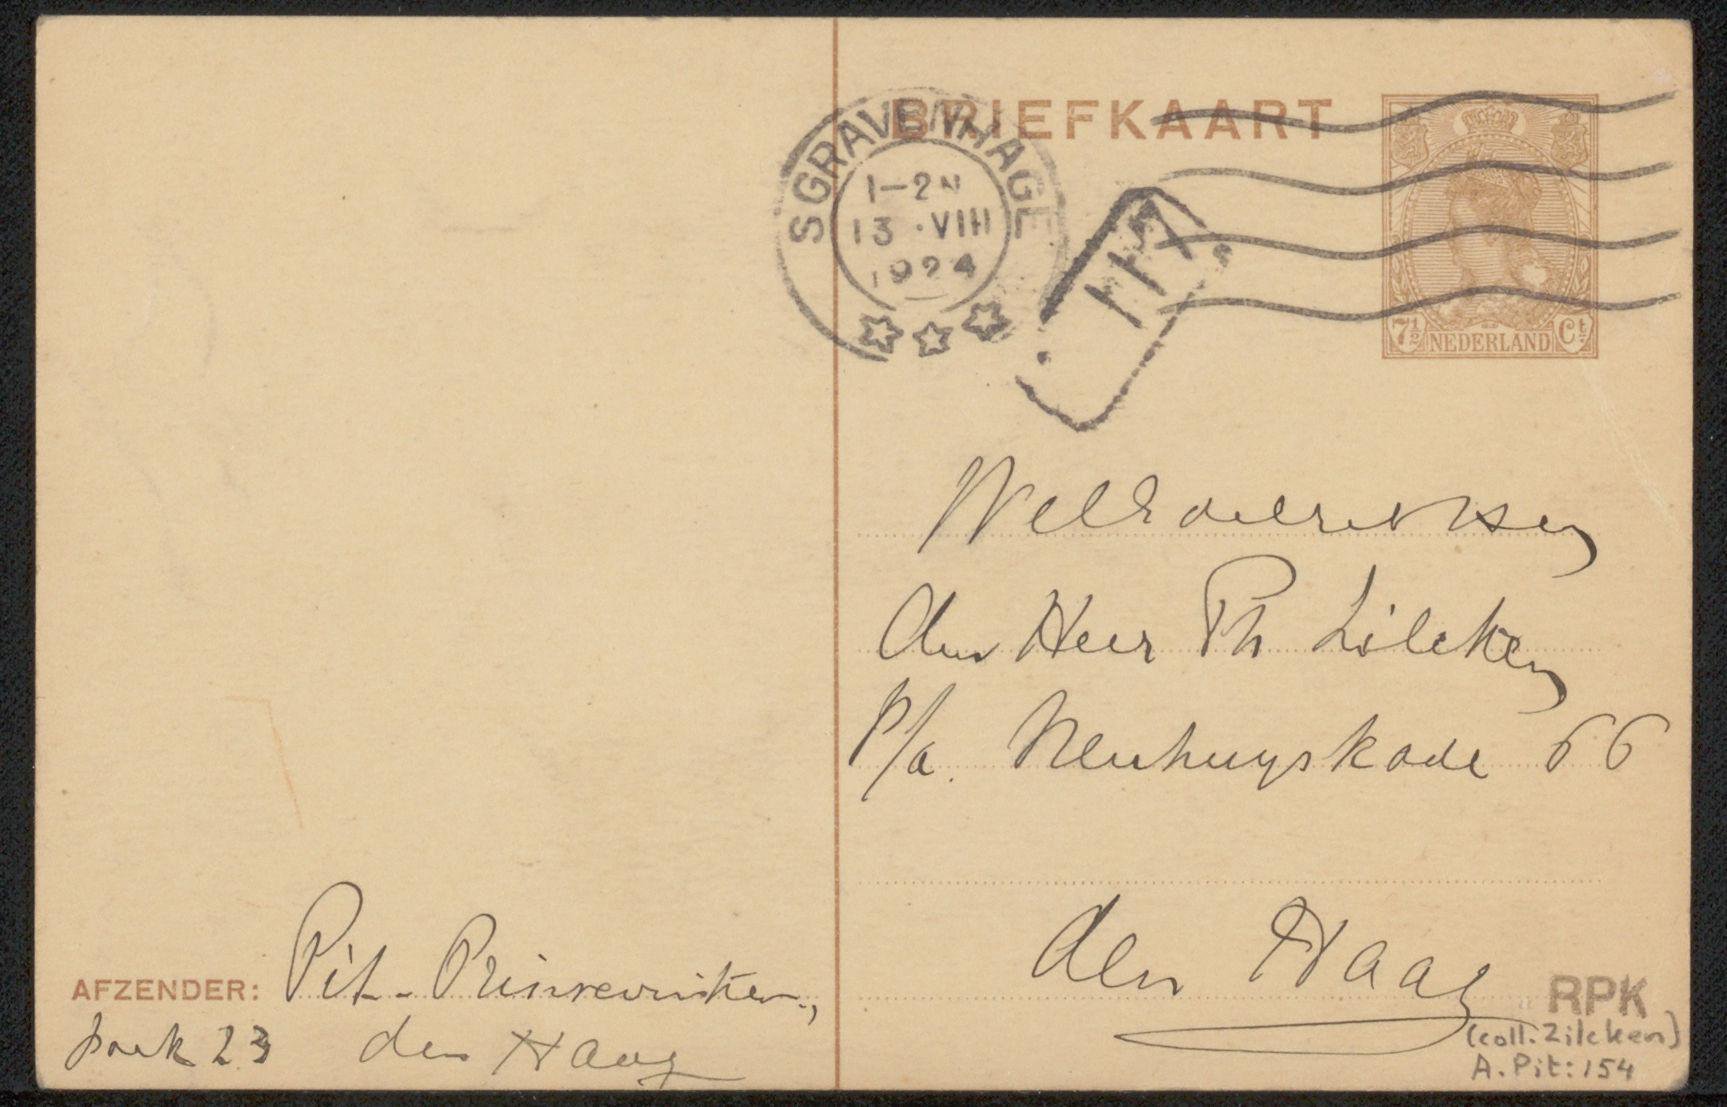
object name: postcard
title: Briefkaart aan Philip Zilcken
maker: adriaan pit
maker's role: print maker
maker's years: 1860-1944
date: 1924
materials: cardboard, ink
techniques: pen, writing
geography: the hague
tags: draughtsman, philip zilcken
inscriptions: collector's mark: ‘RPK’